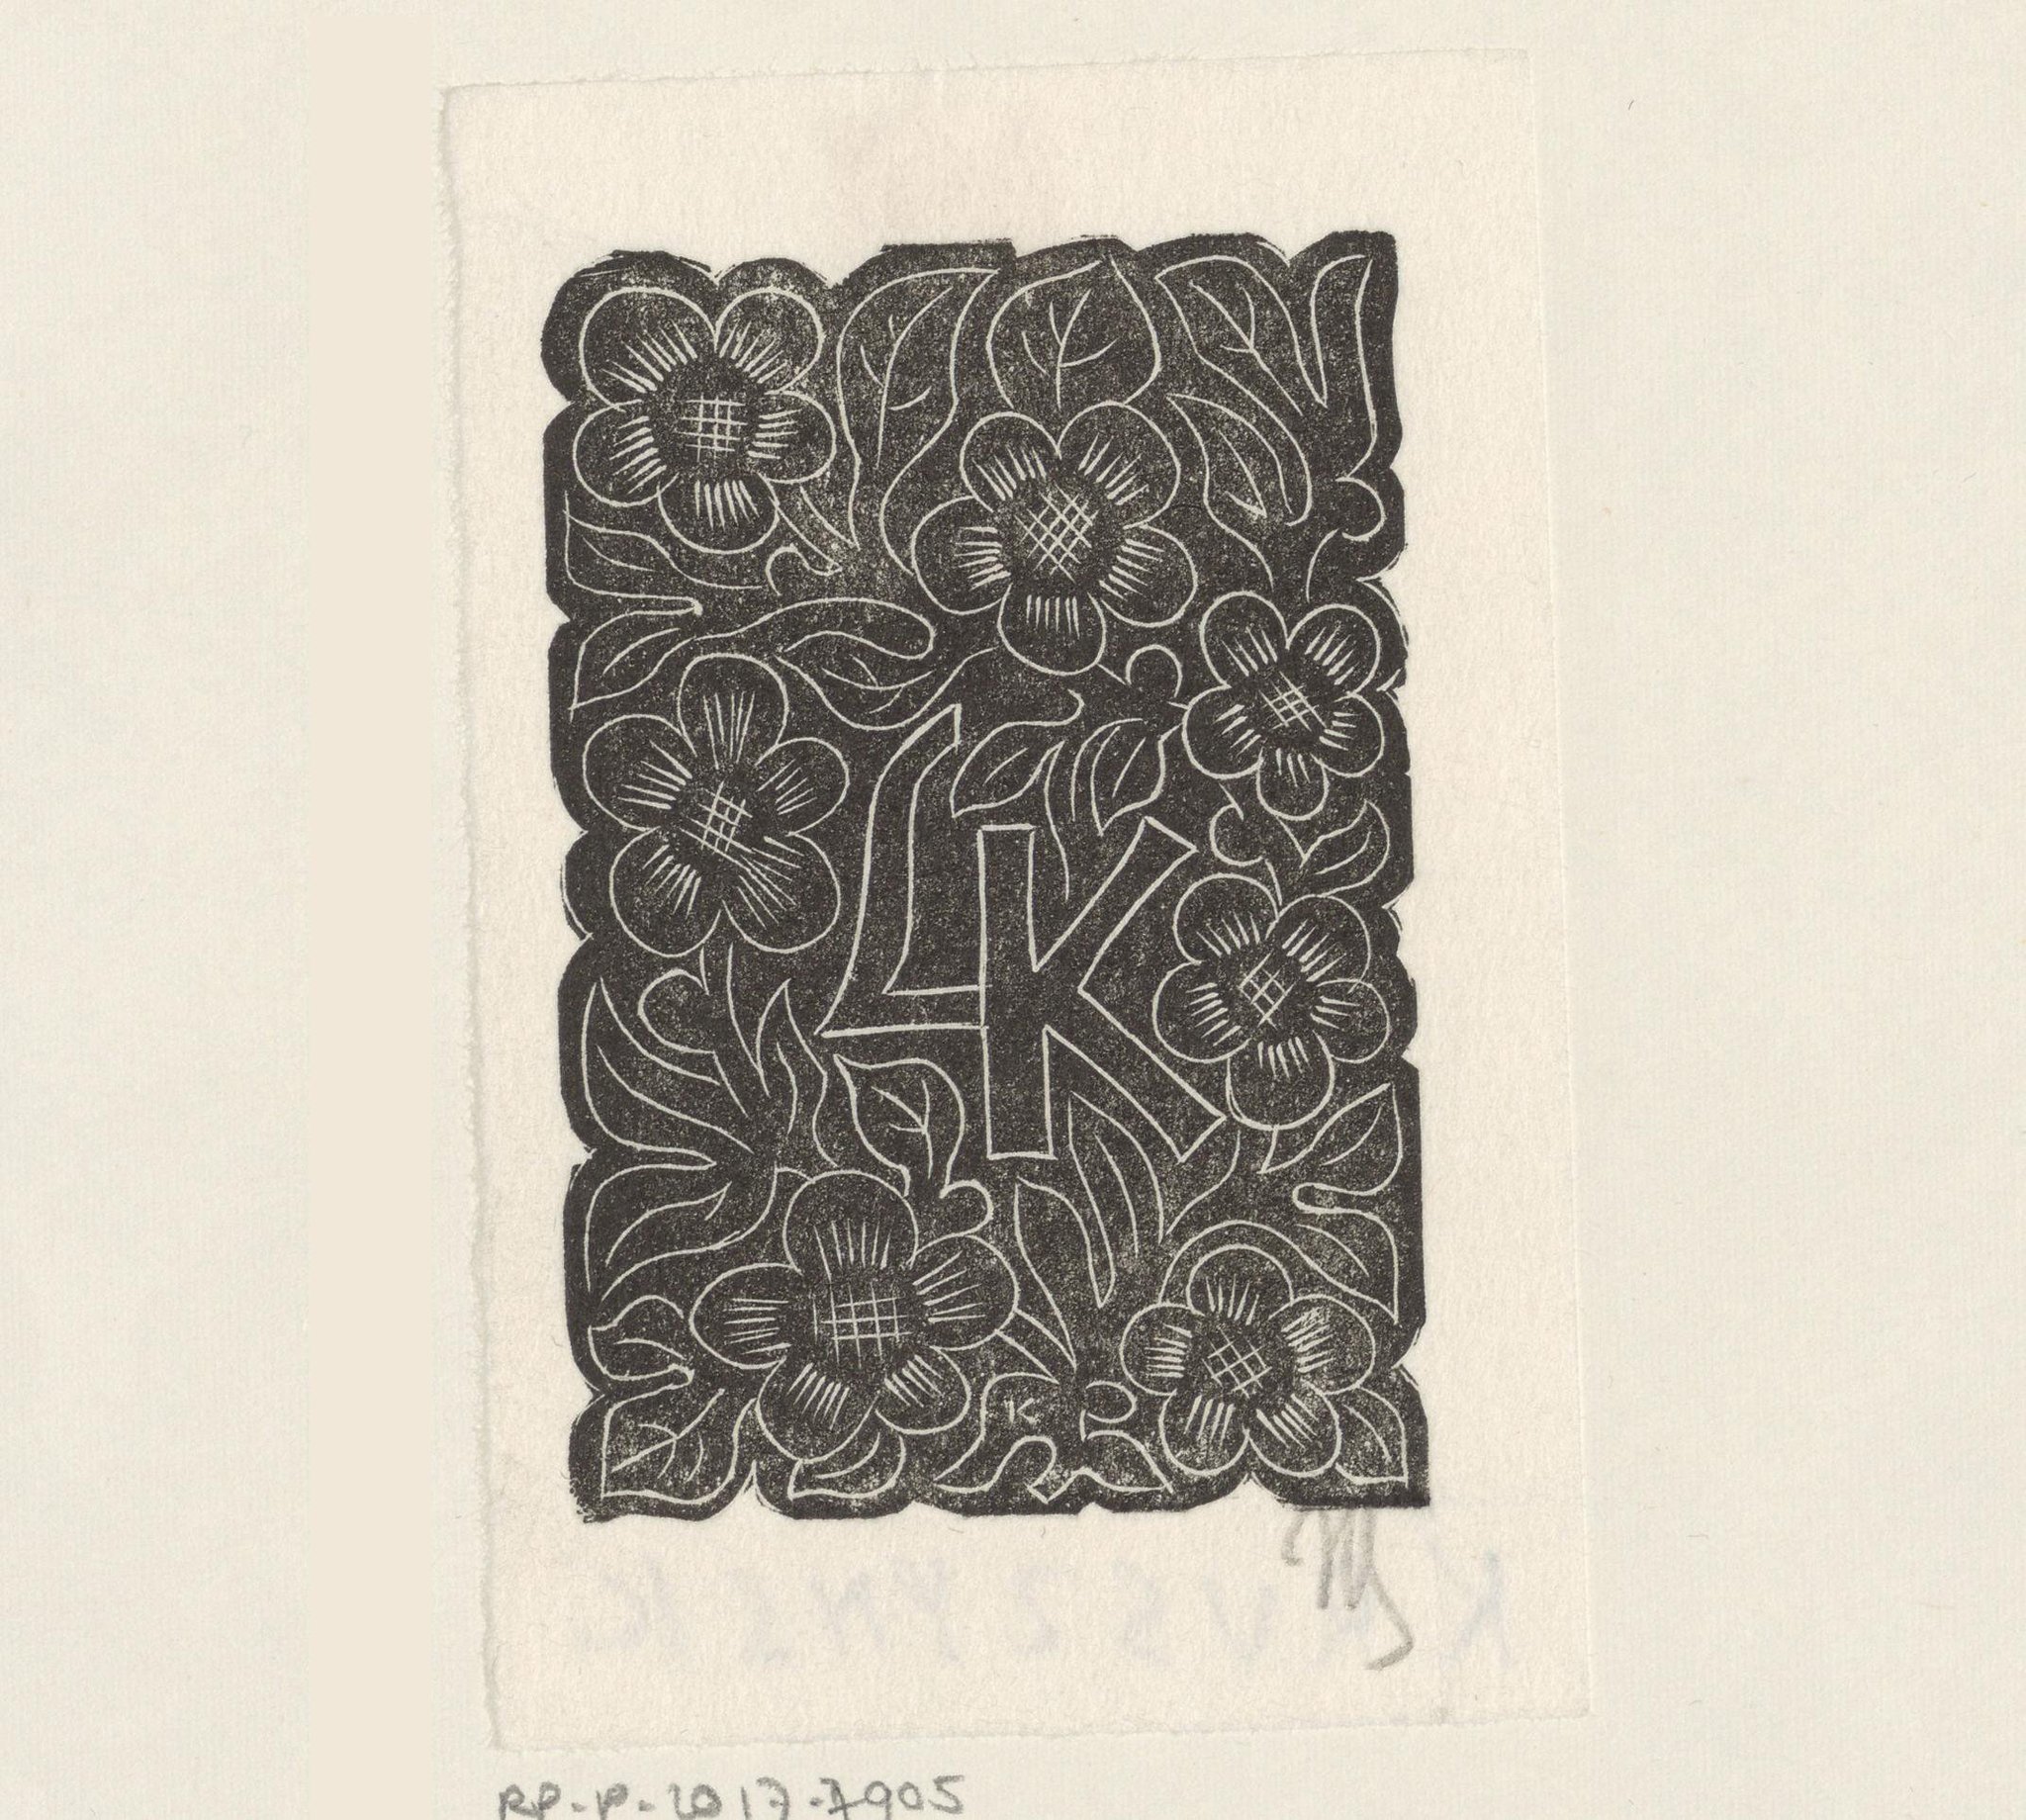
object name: bookplate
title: Ex libris van L.K.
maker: jan kruszynski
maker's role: print maker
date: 1900-1999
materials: paper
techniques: woodcut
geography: poland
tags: flowers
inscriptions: monogram